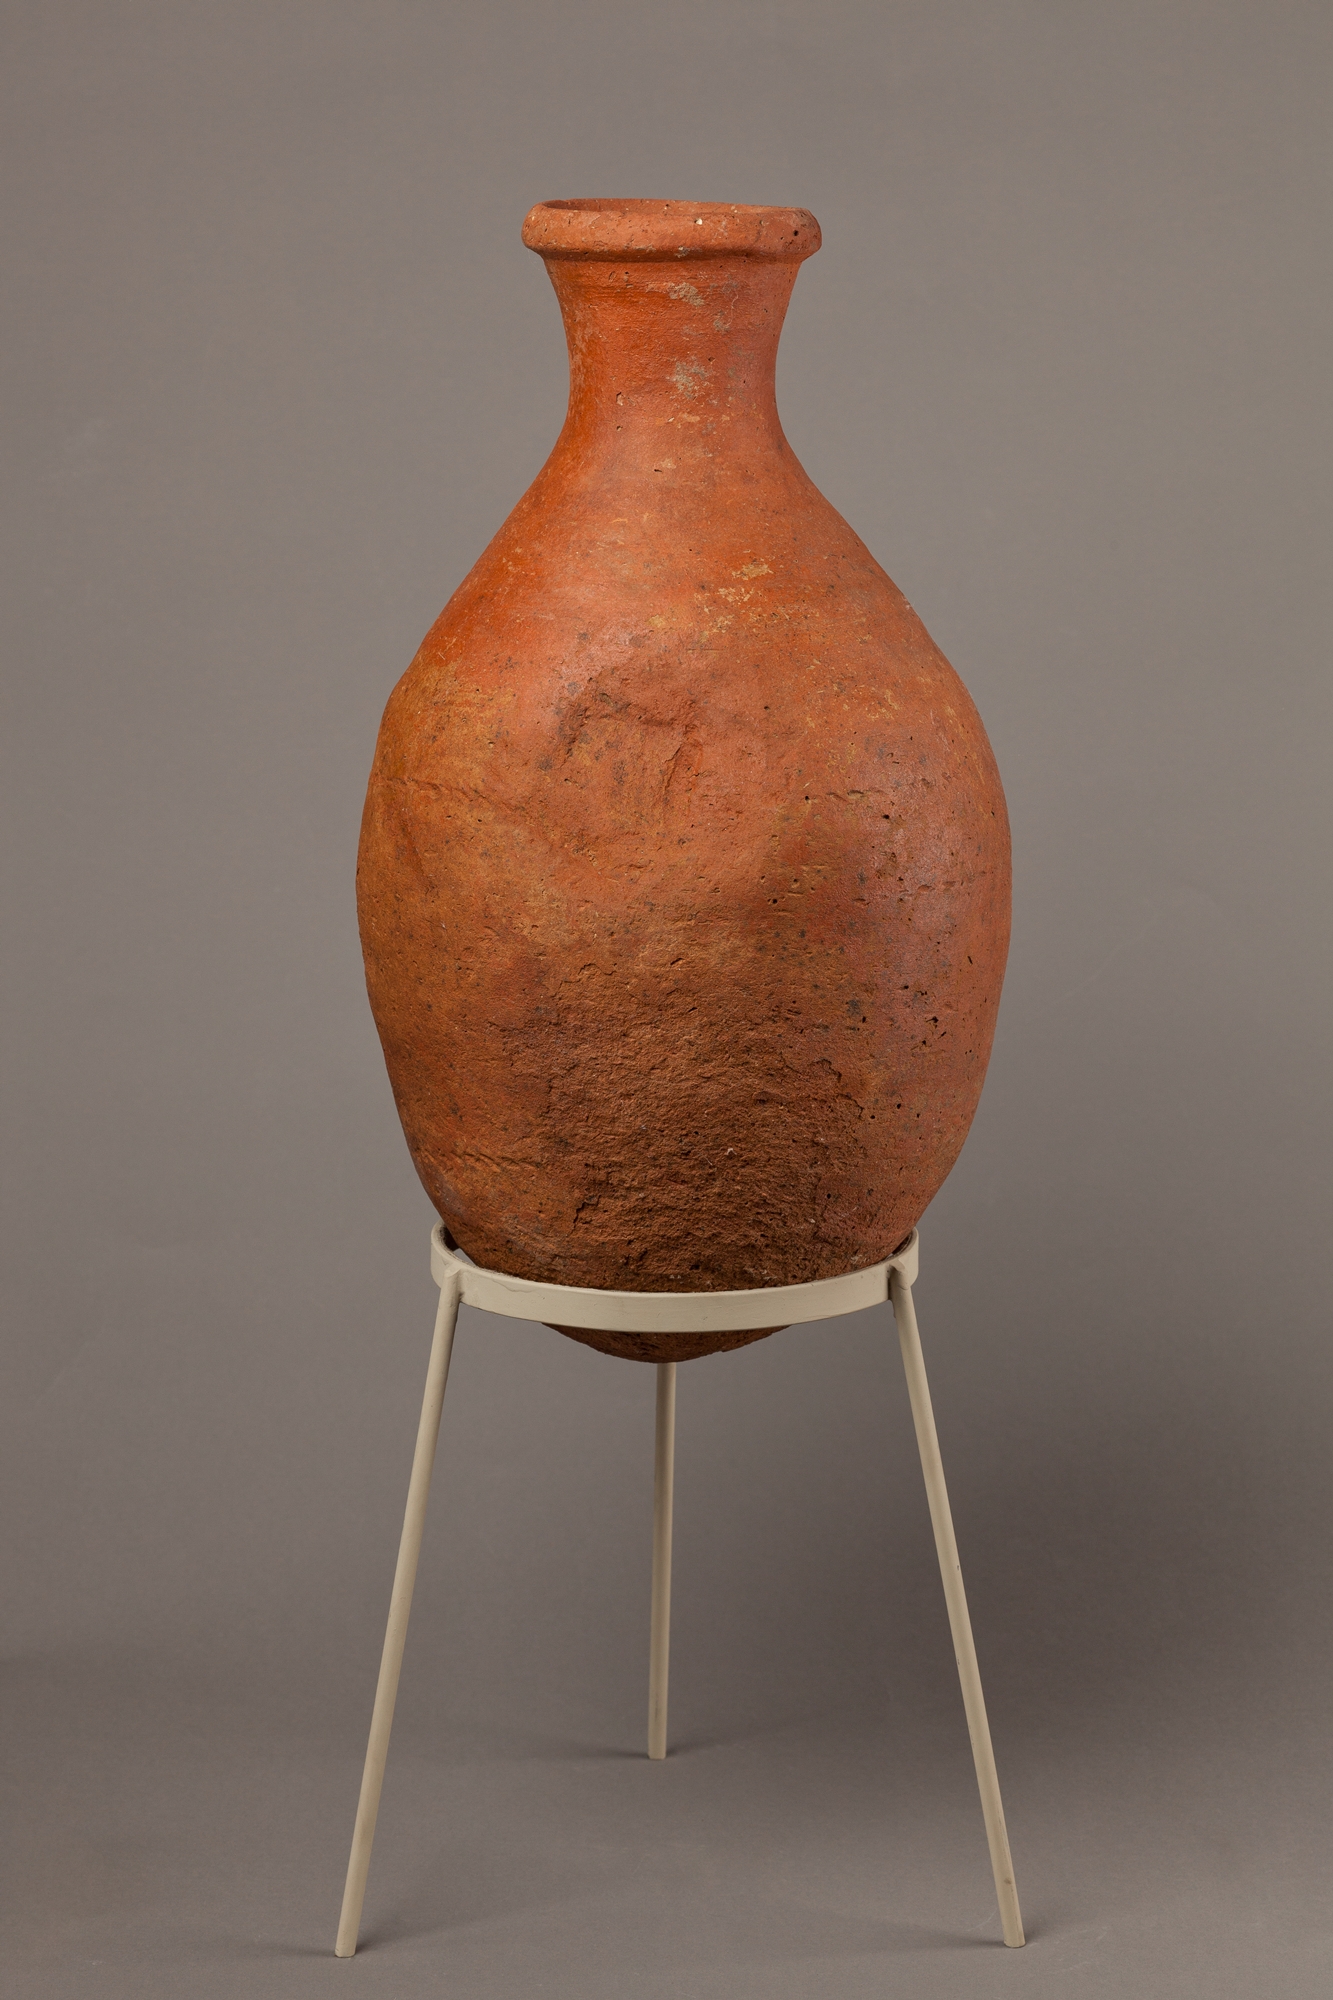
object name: jar, water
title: Large water jar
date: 2030-1640 BCE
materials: pottery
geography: egypt